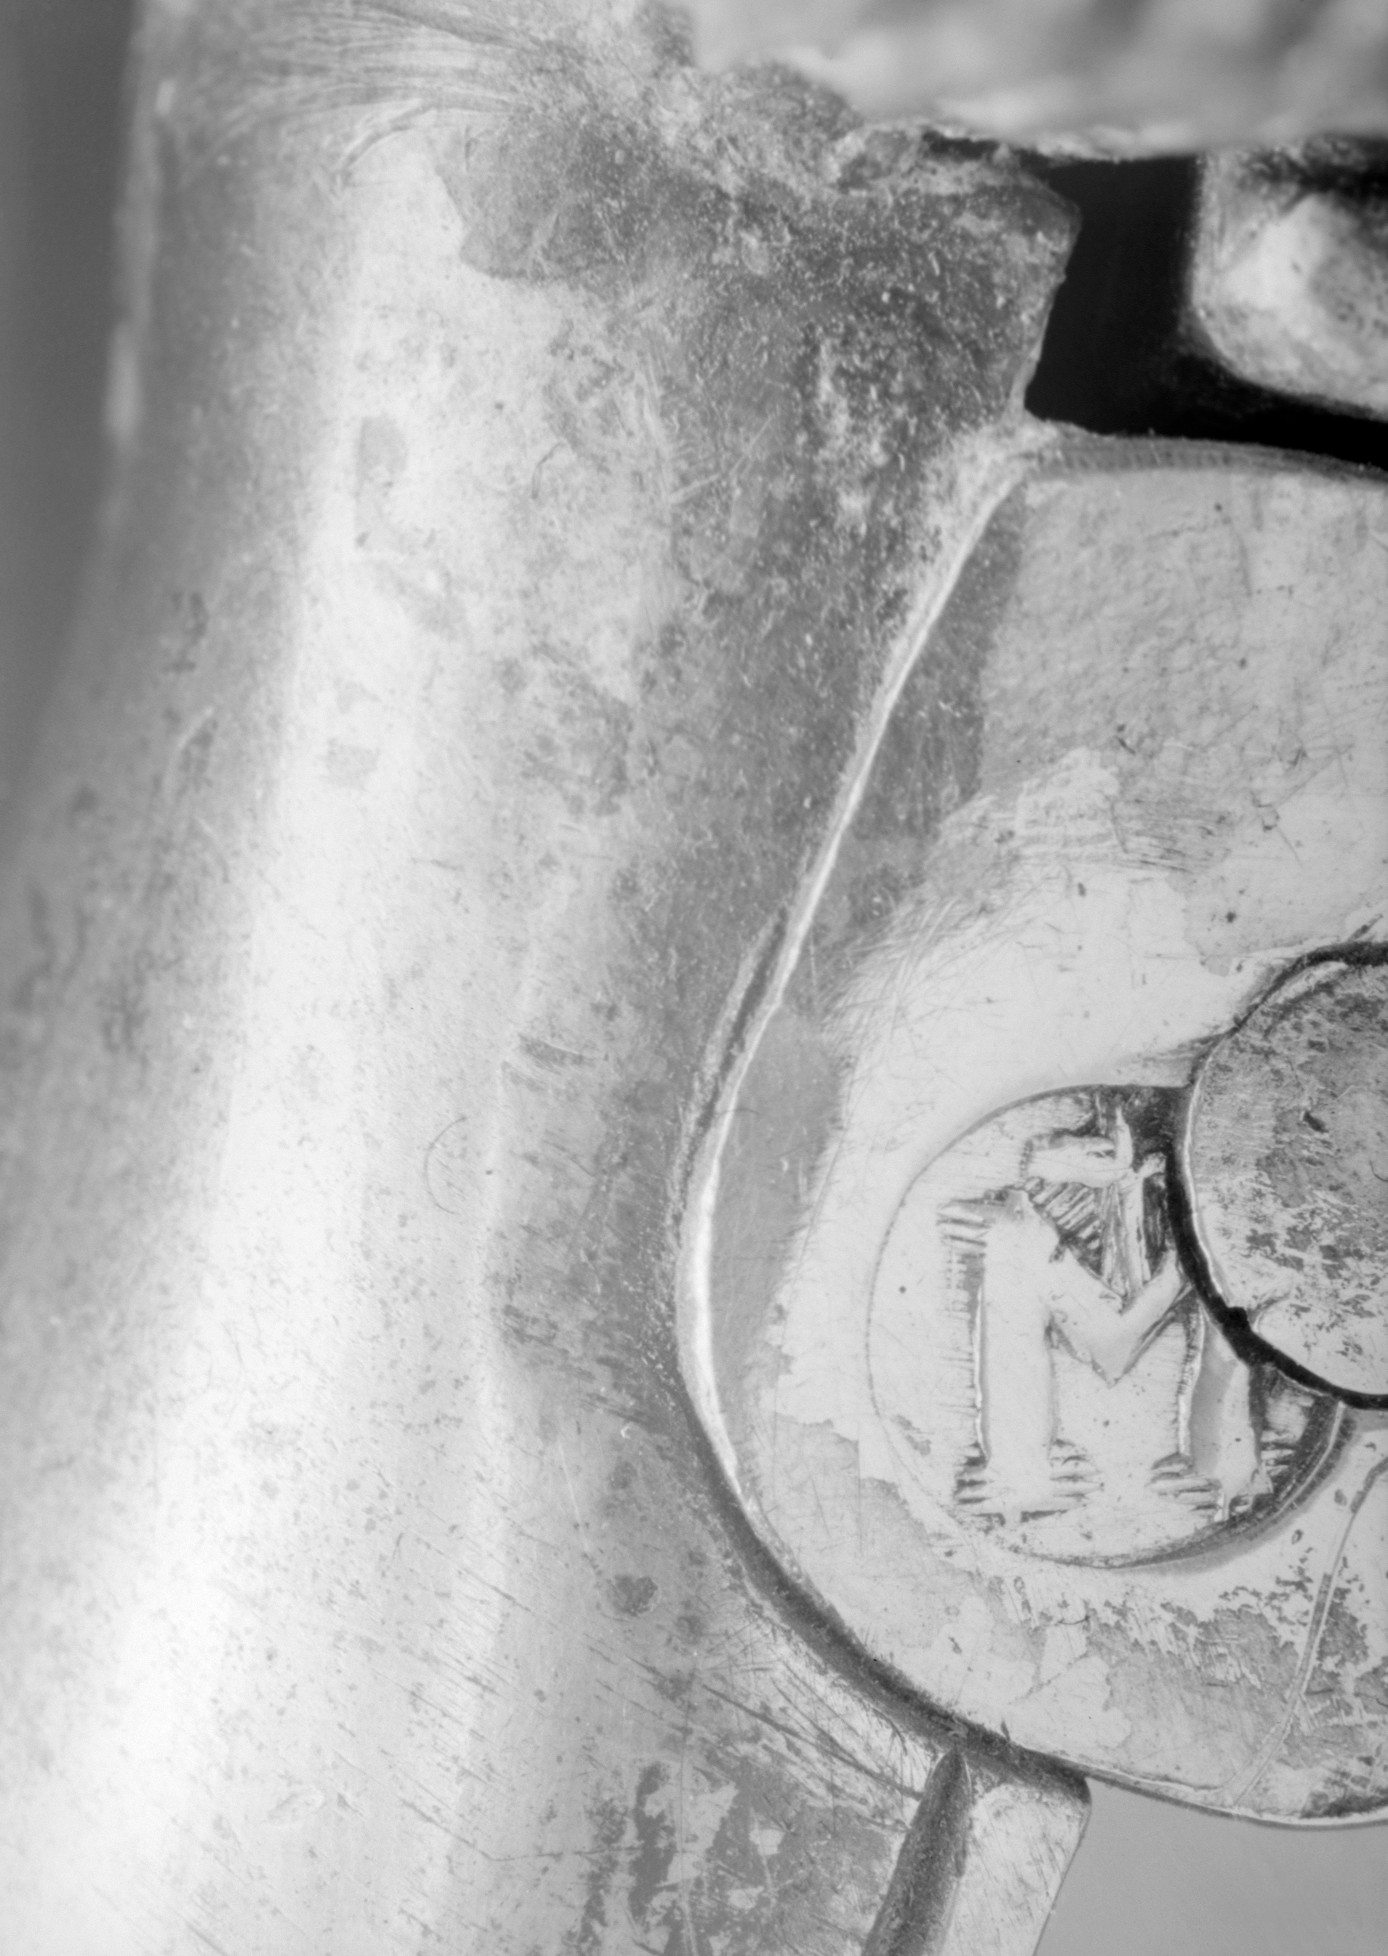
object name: flagon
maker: ulrich möringer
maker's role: maker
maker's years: 1481-1581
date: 1551-1575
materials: gilt, silver